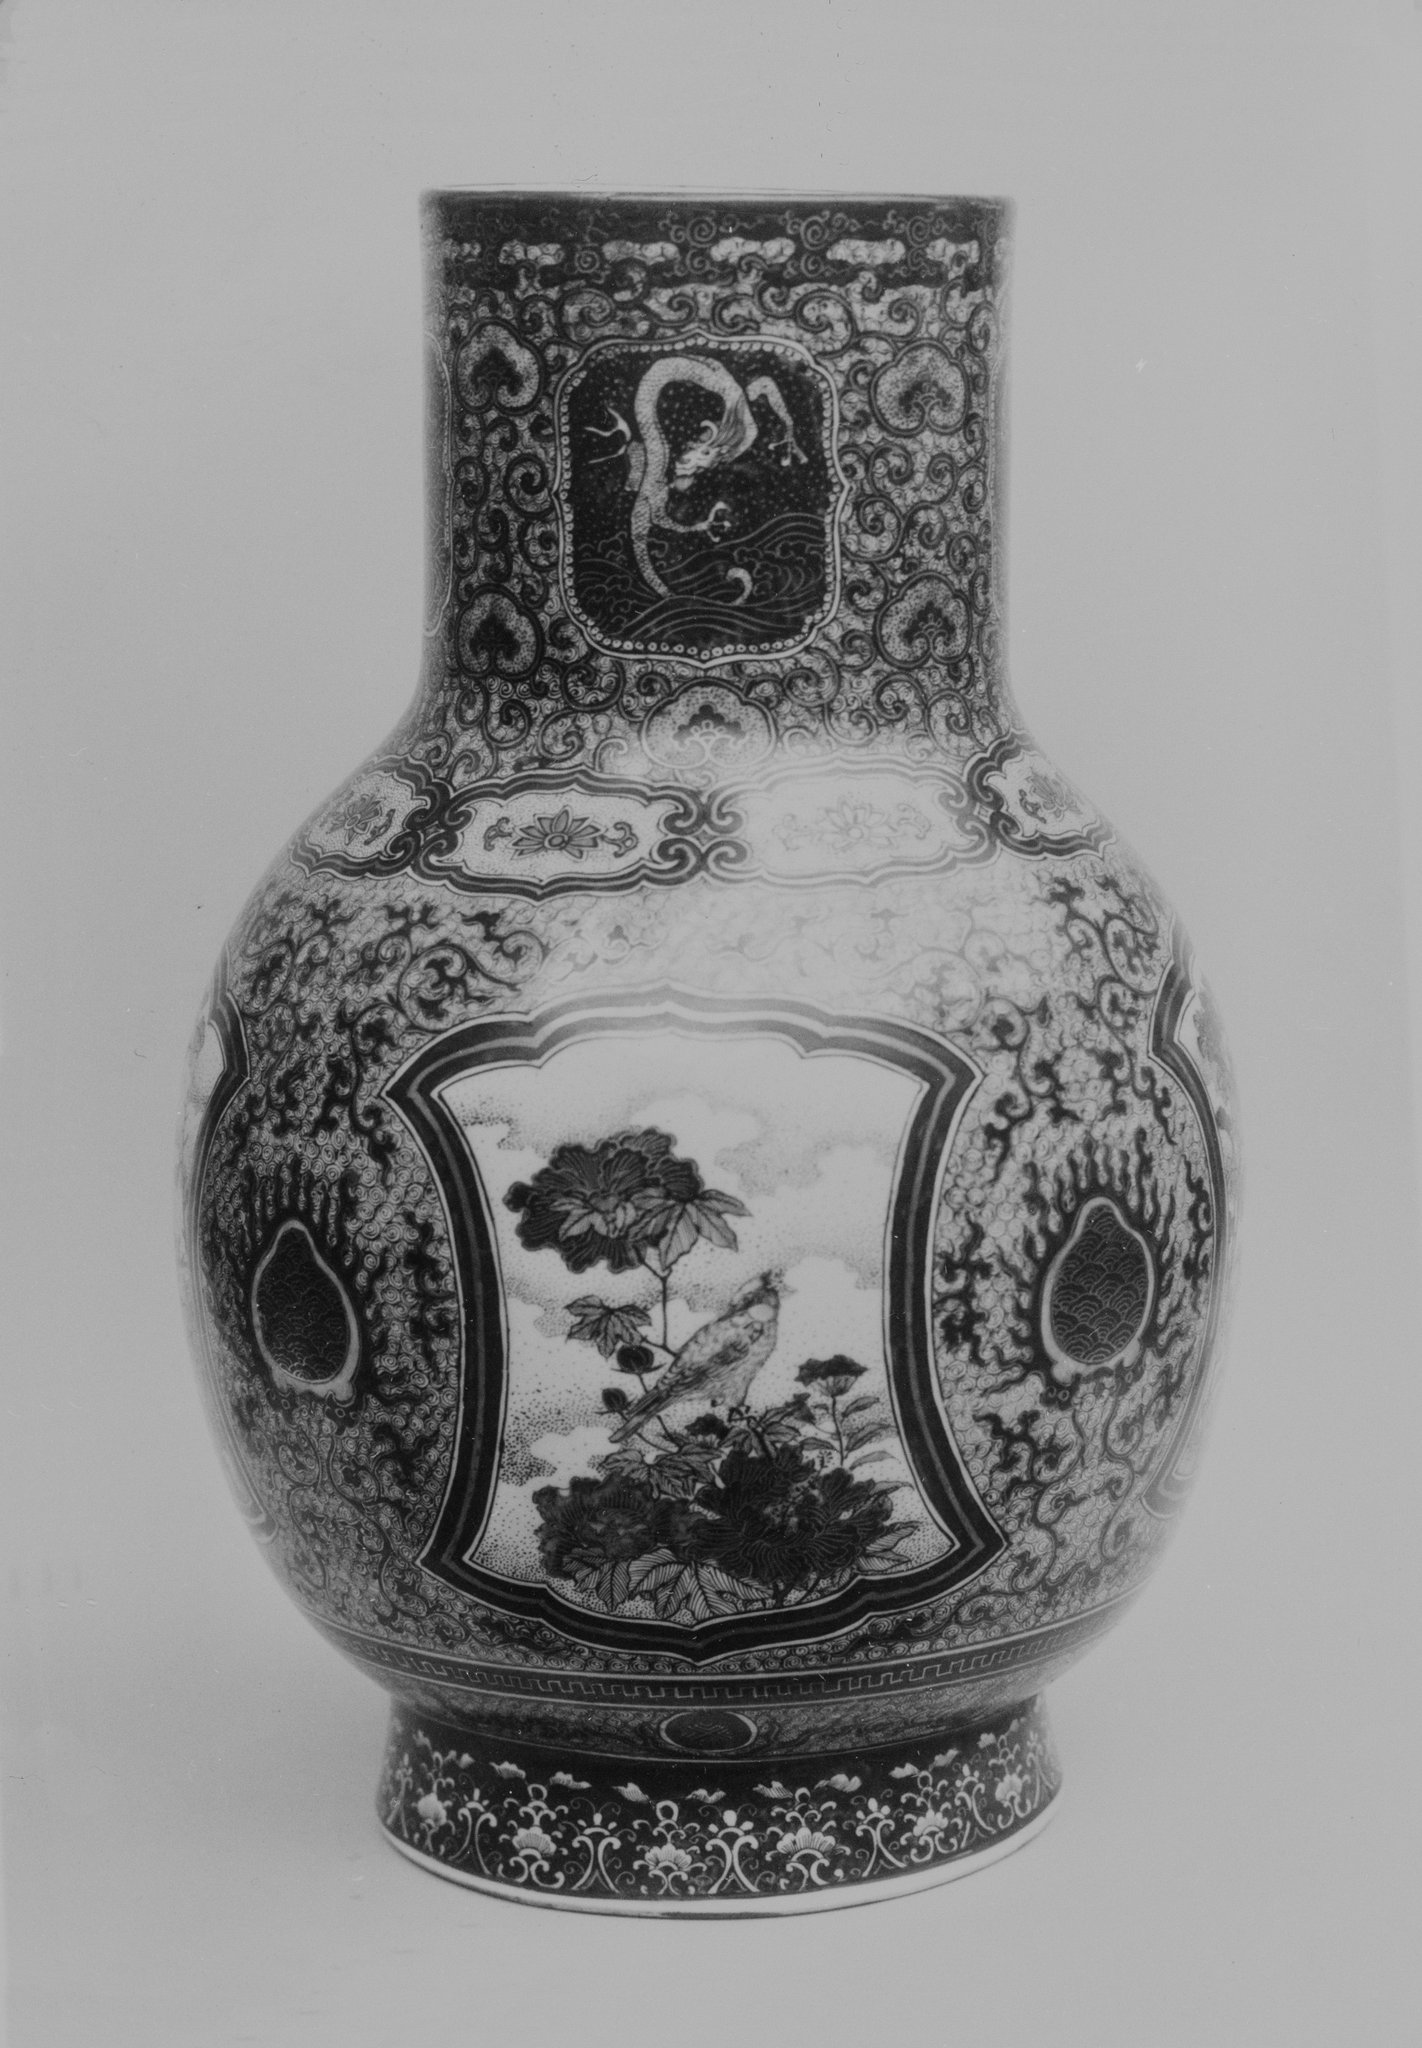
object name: vase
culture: japanese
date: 1855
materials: gold, porcelain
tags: mythical creatures,flowers